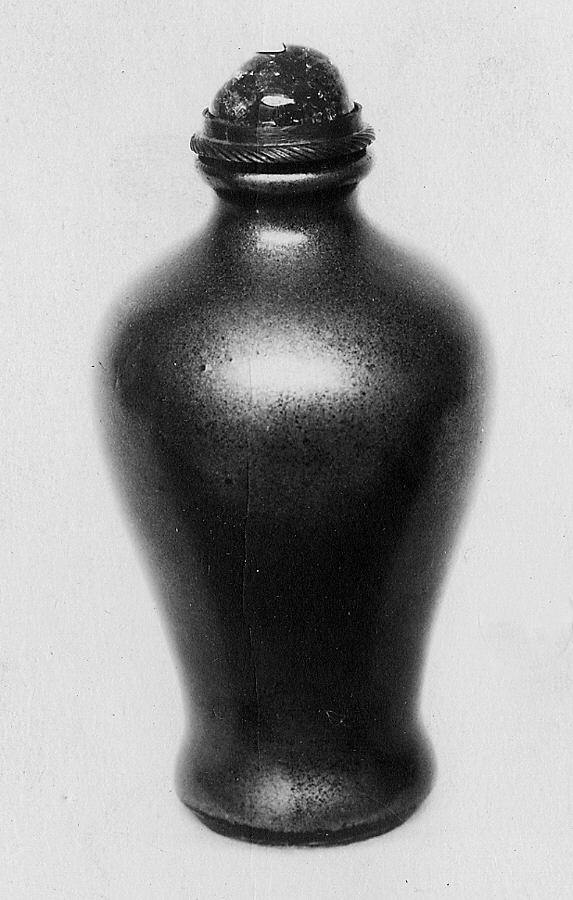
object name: snuff bottle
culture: chinese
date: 1736-1795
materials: porcelain